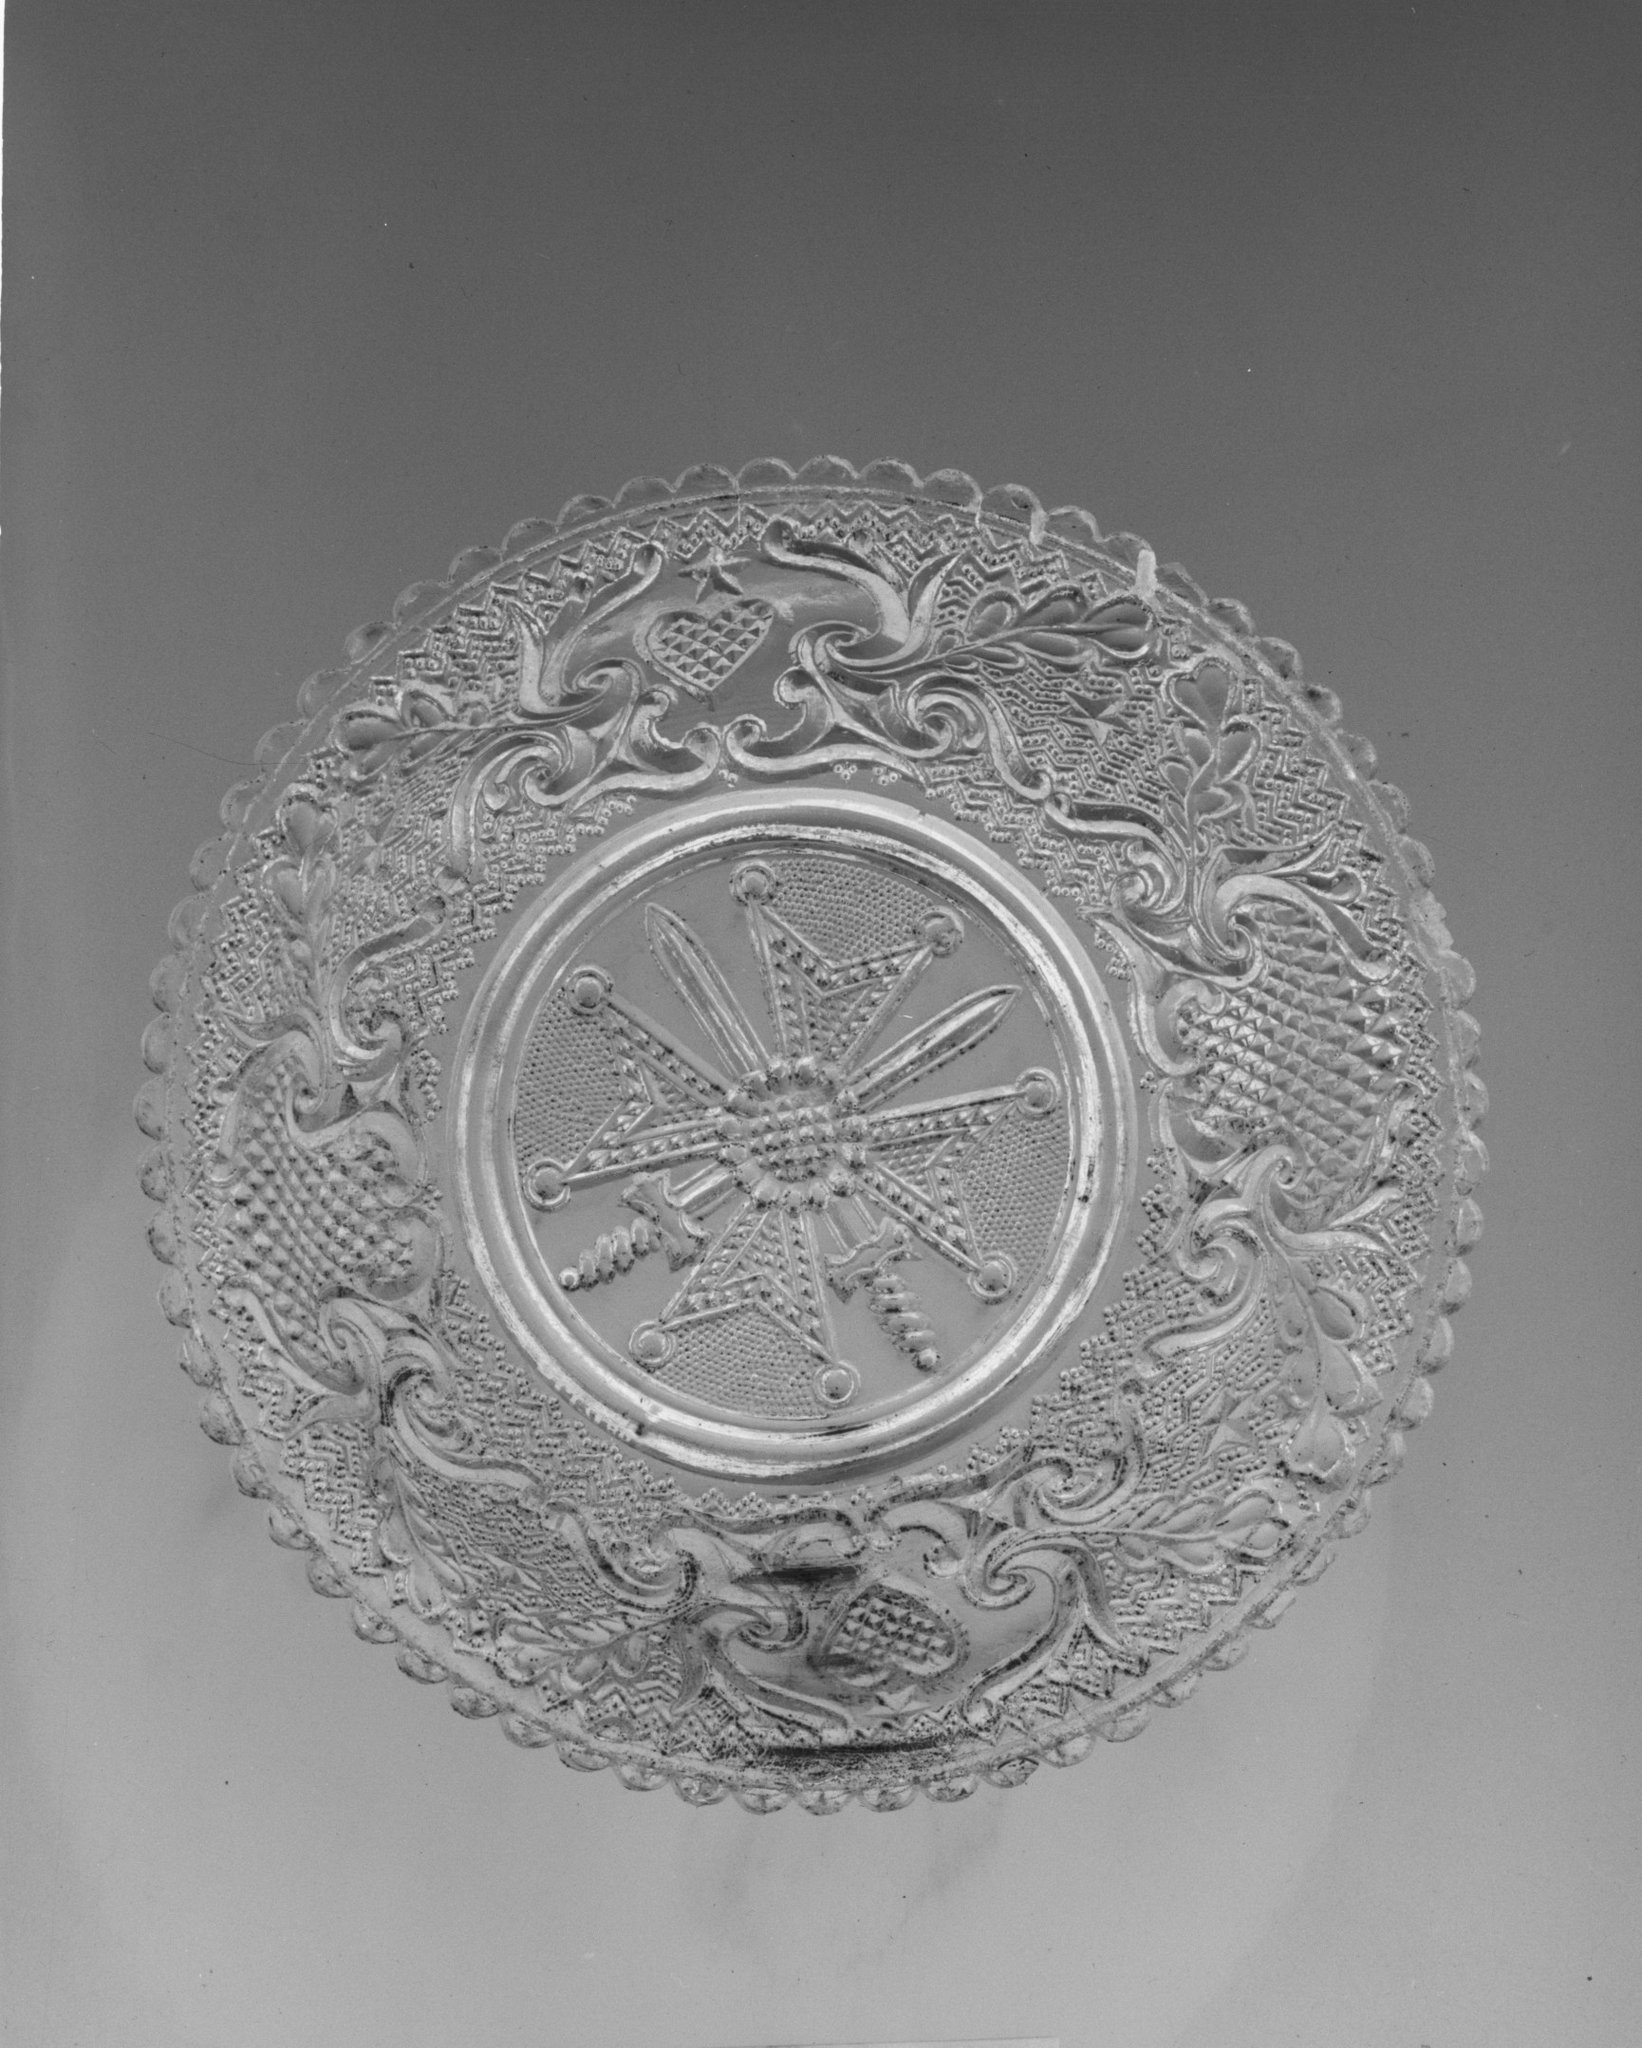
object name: bowl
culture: american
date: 1830-1845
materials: glass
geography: united states